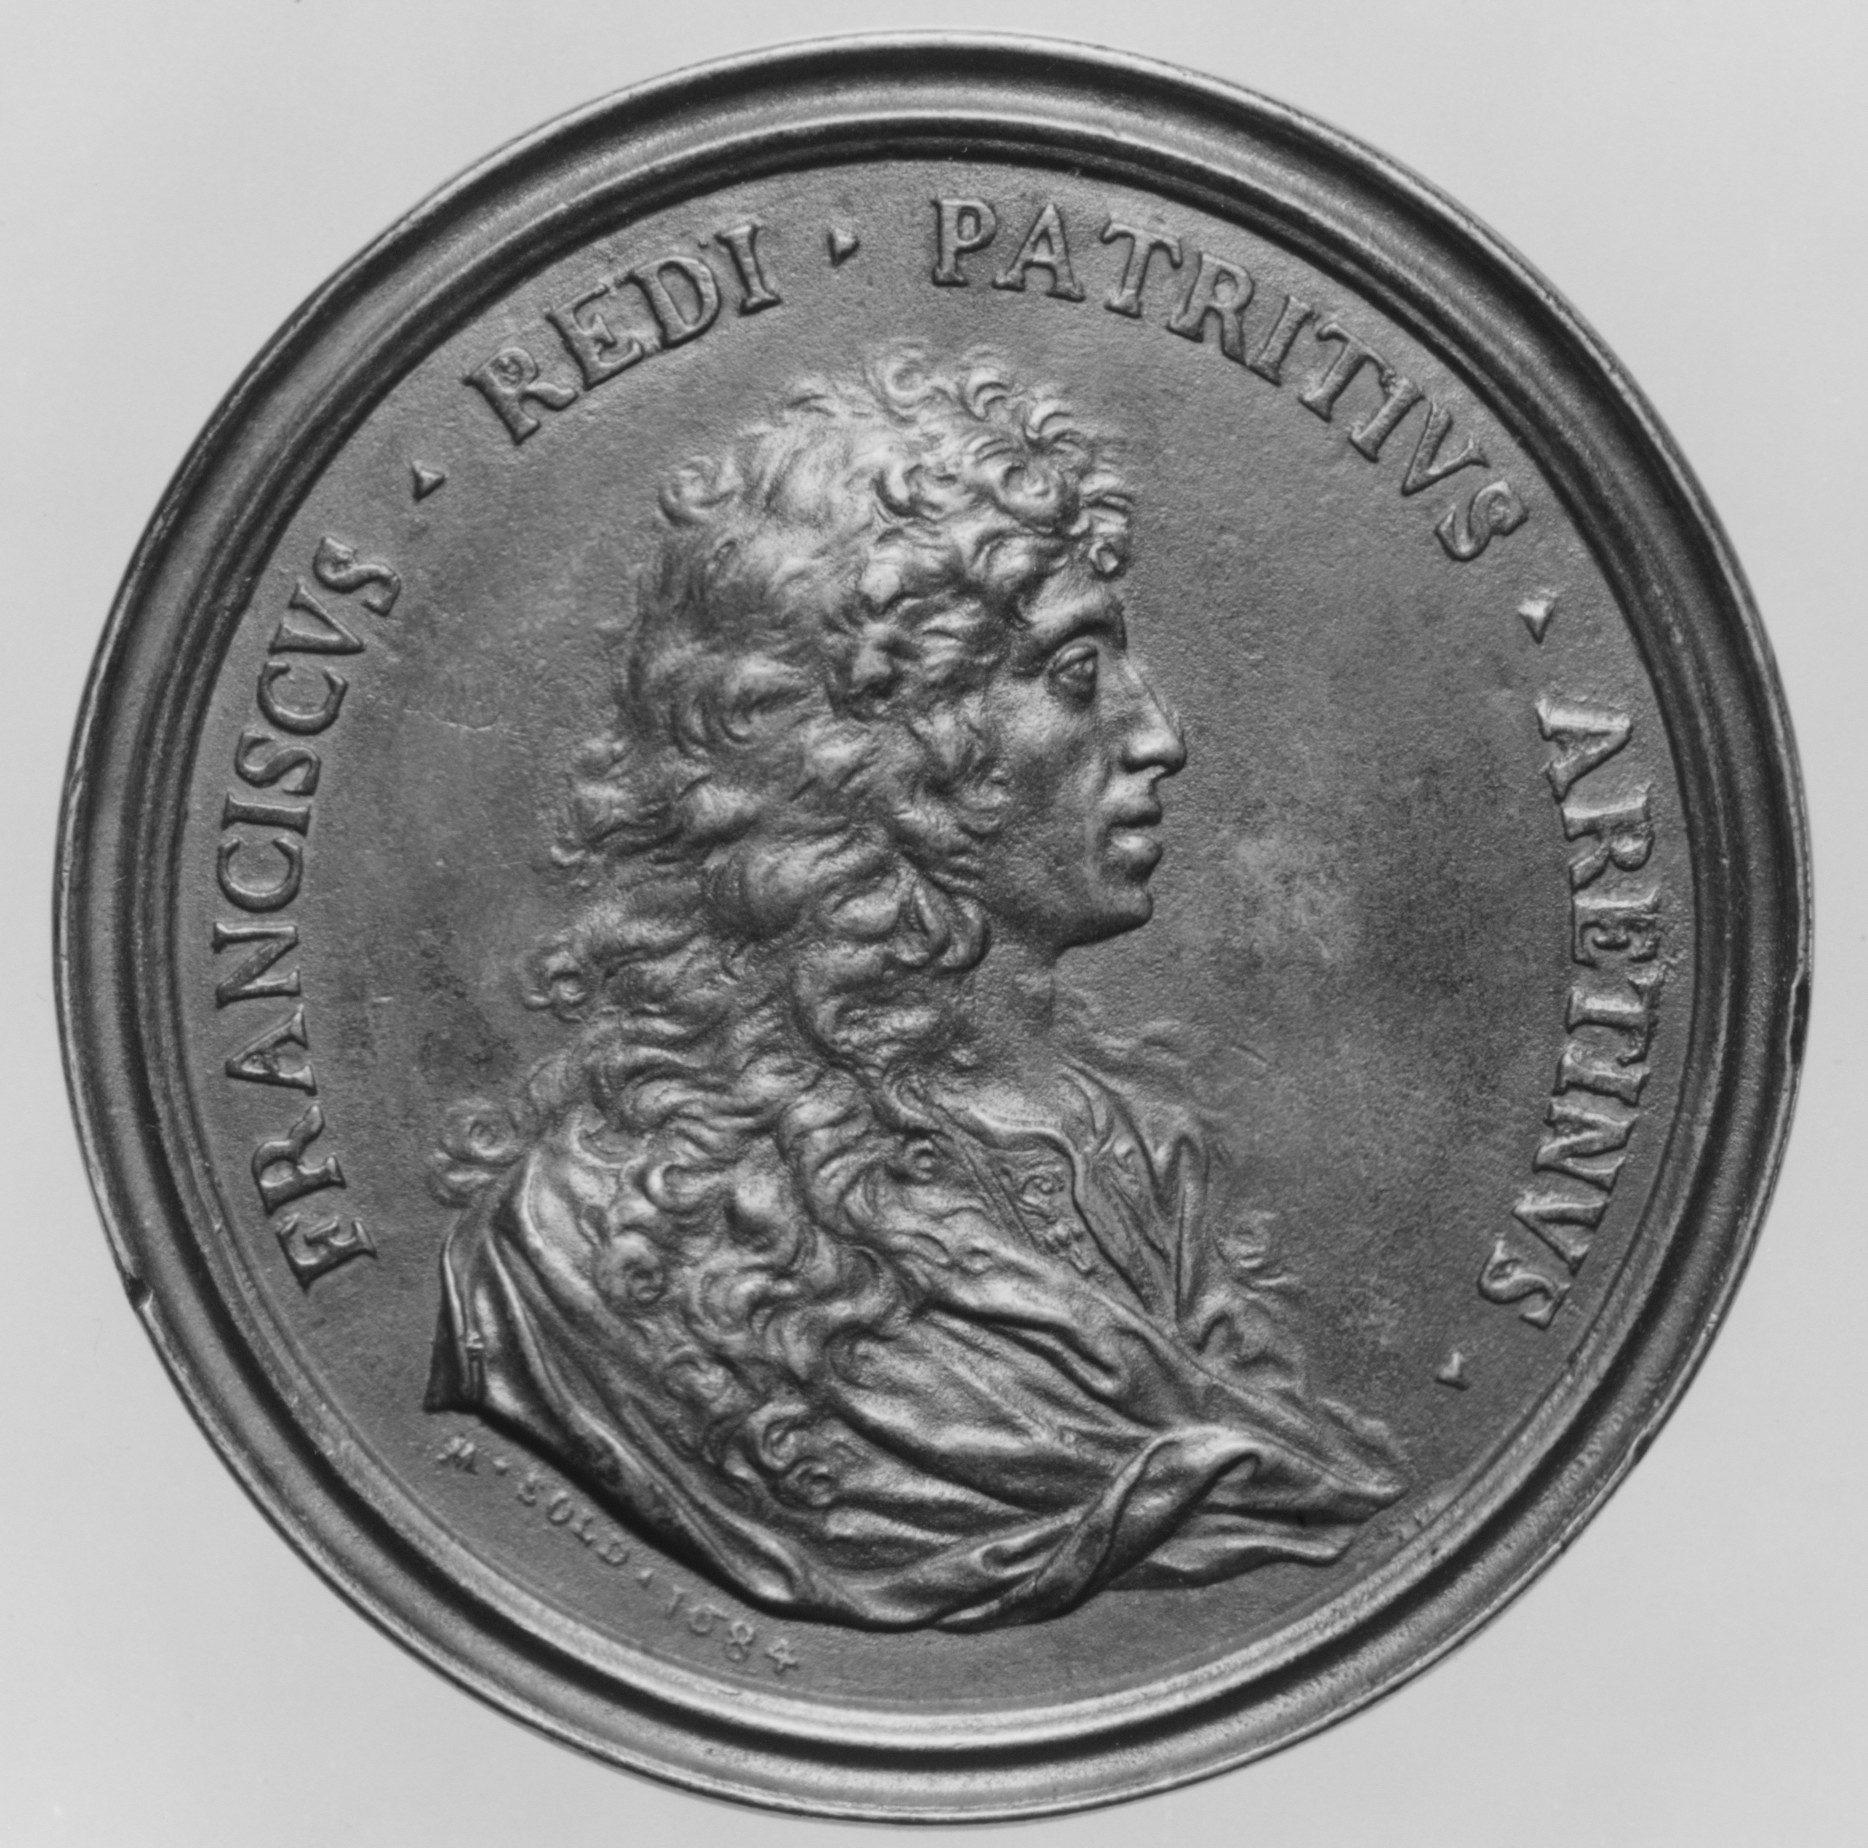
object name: medal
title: Francesco Redi (1628–98)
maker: massimiliano soldani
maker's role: artist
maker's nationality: italian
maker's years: 1656-1740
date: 1684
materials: bronze, patina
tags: men,male nudes,profiles,horses